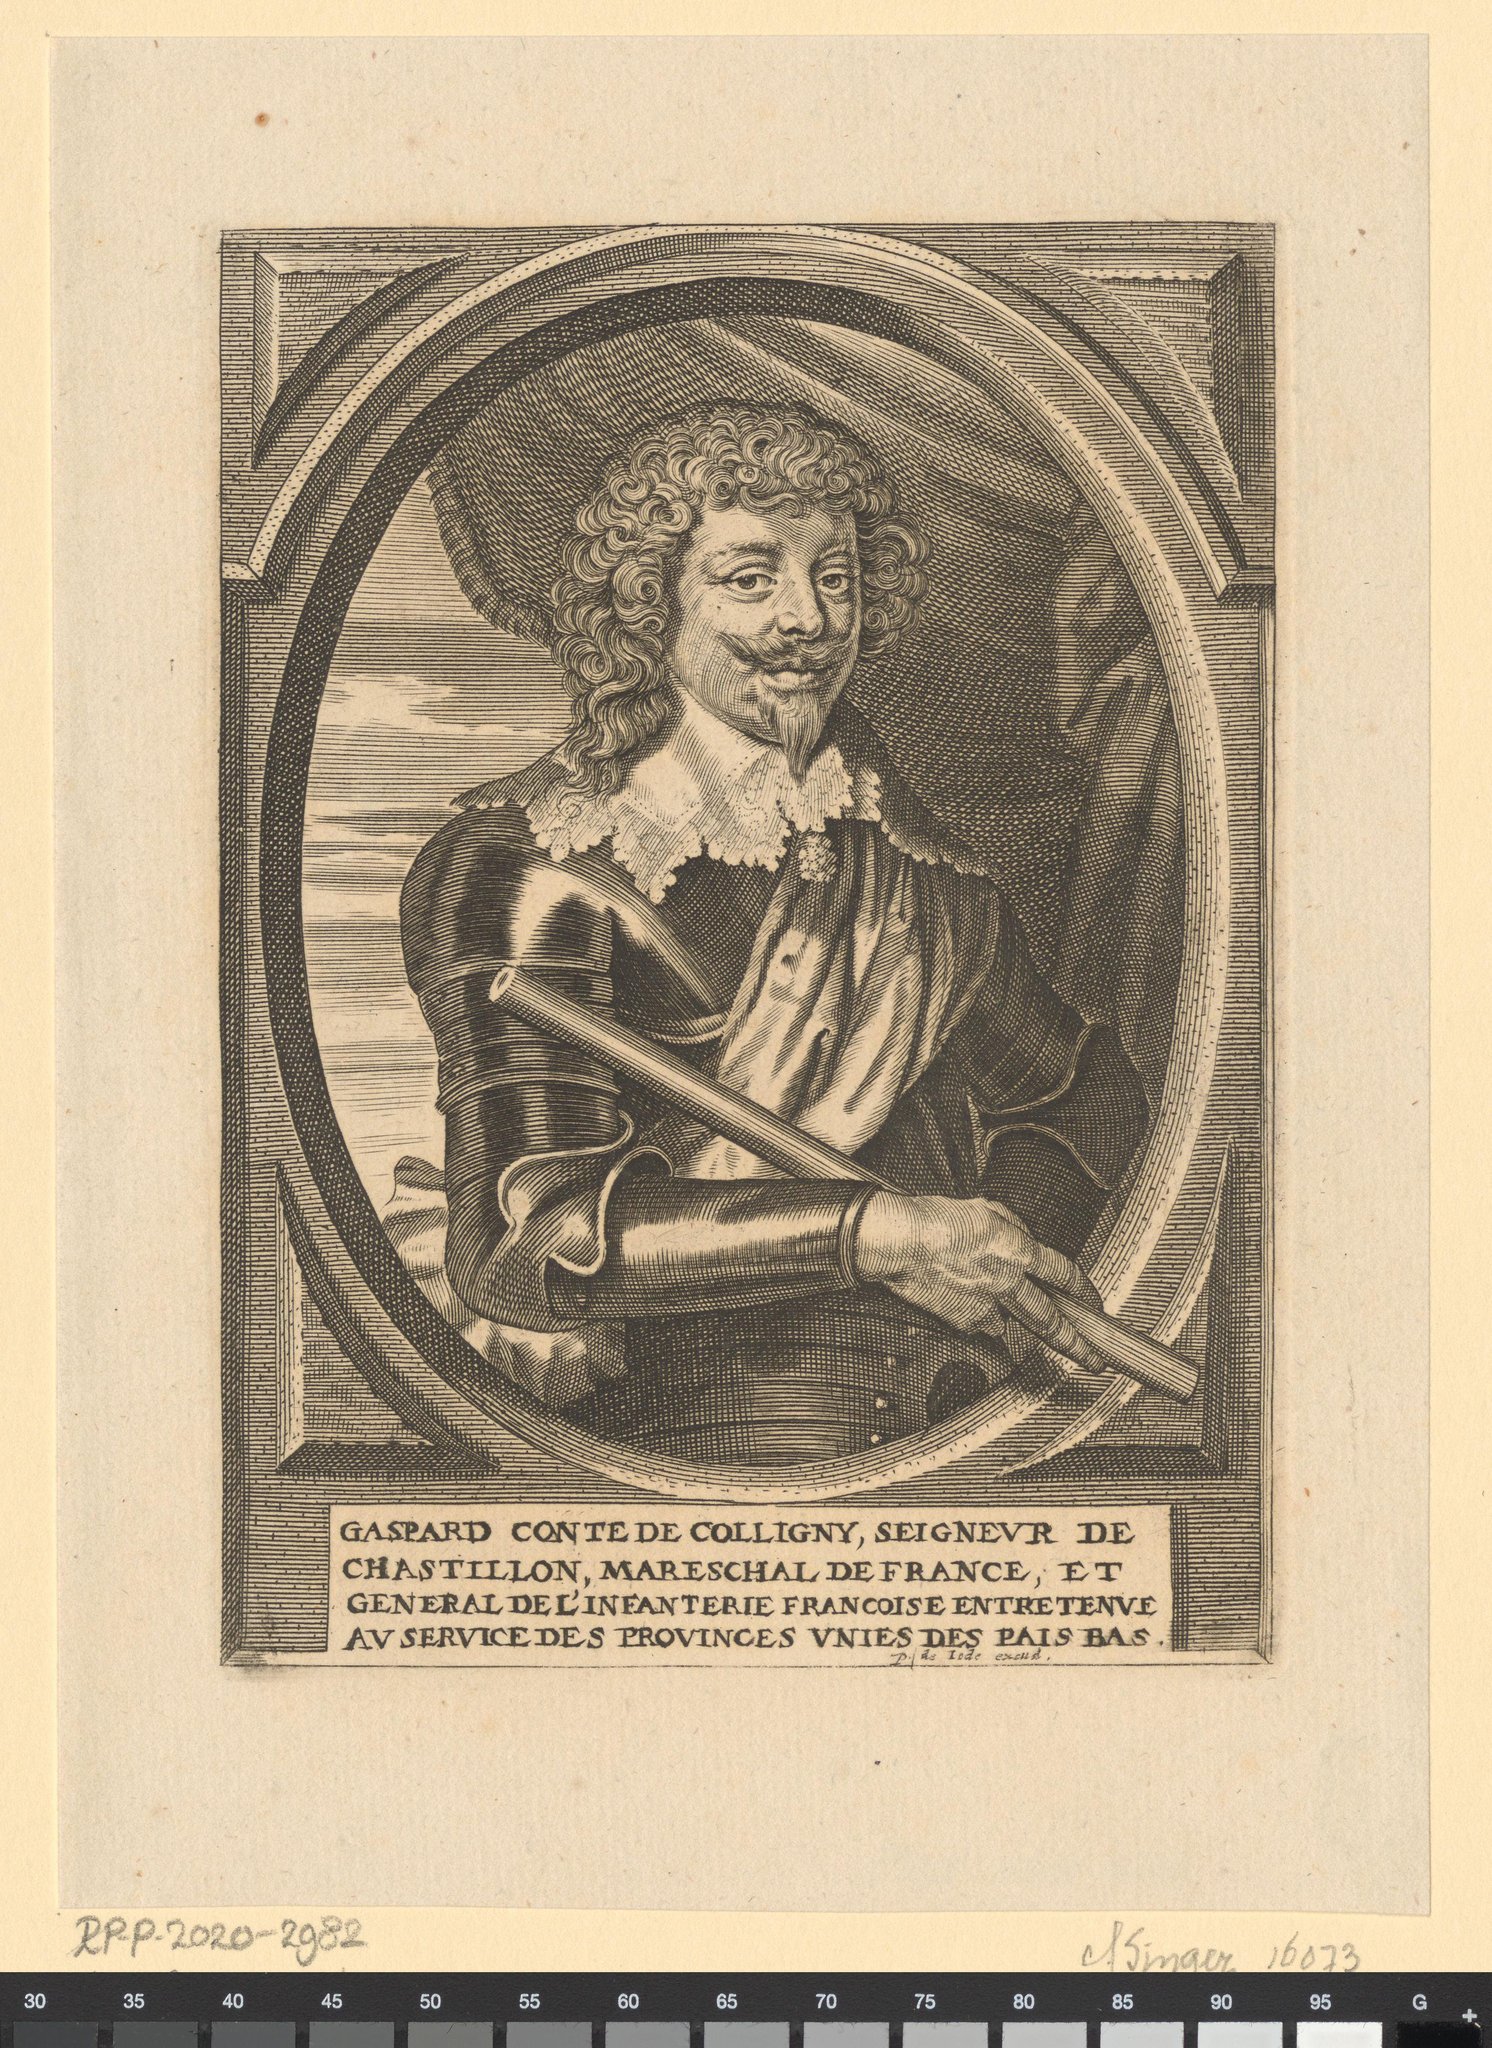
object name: print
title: Portret van Gaspard de Coligny III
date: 1628-1674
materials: paper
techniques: engraving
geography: amsterdam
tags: historical persons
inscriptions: collector's mark: Lugt 964, inscription: ‘April=89’, collector's mark: Lugt 963